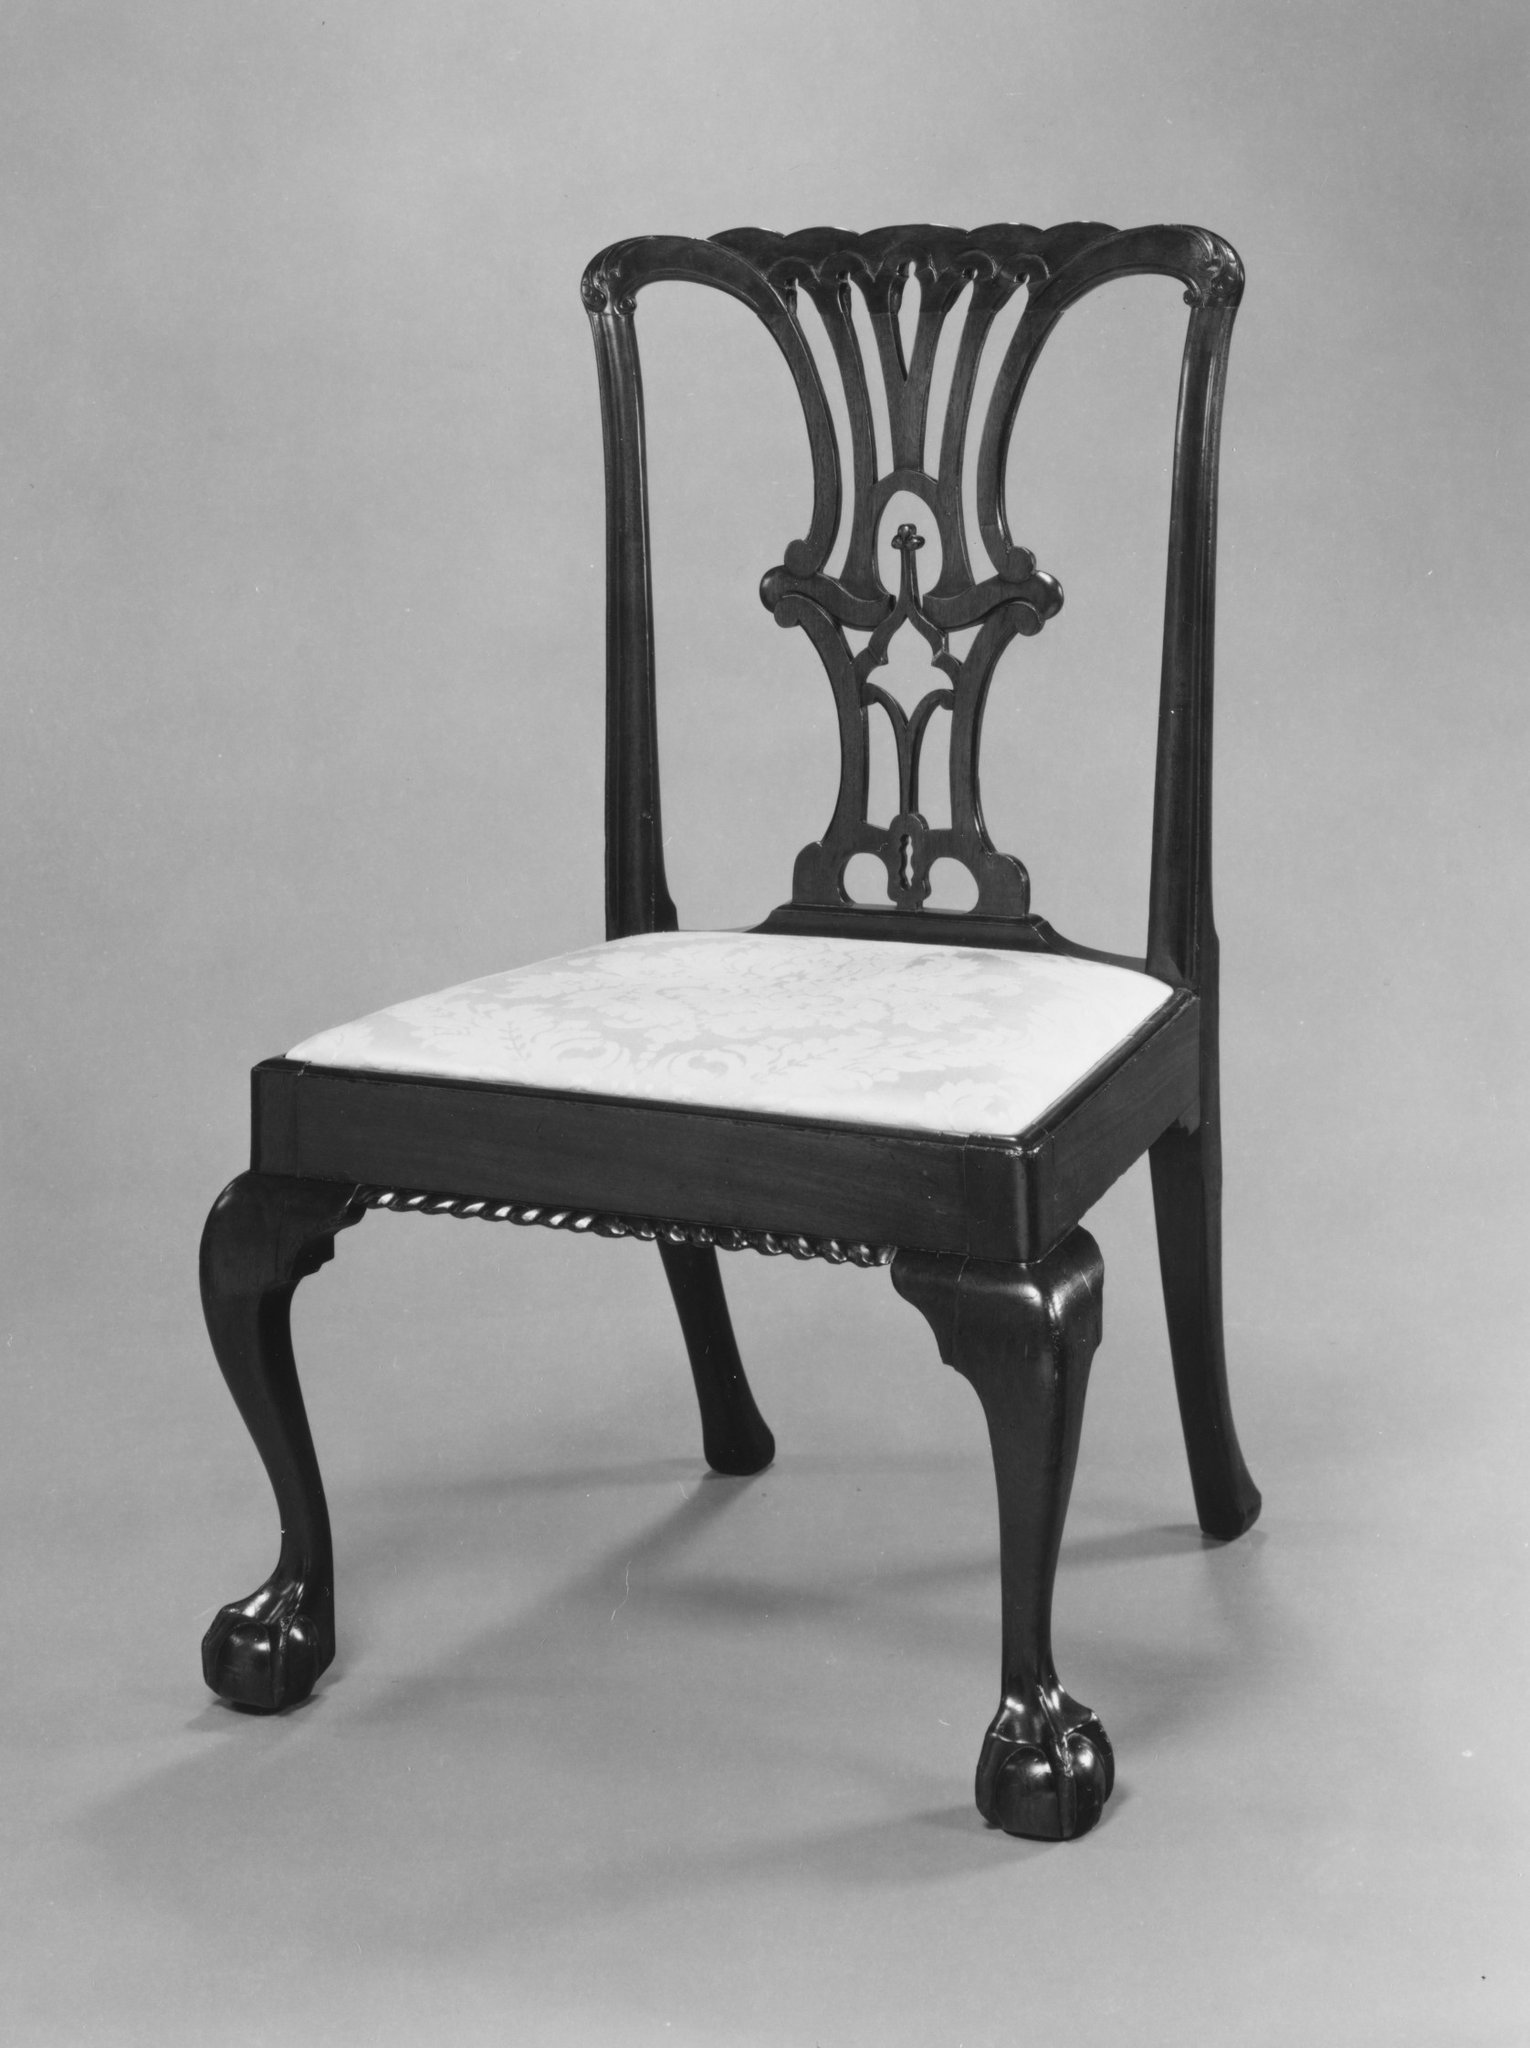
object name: side chair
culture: american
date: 1765-1790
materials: wood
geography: united states